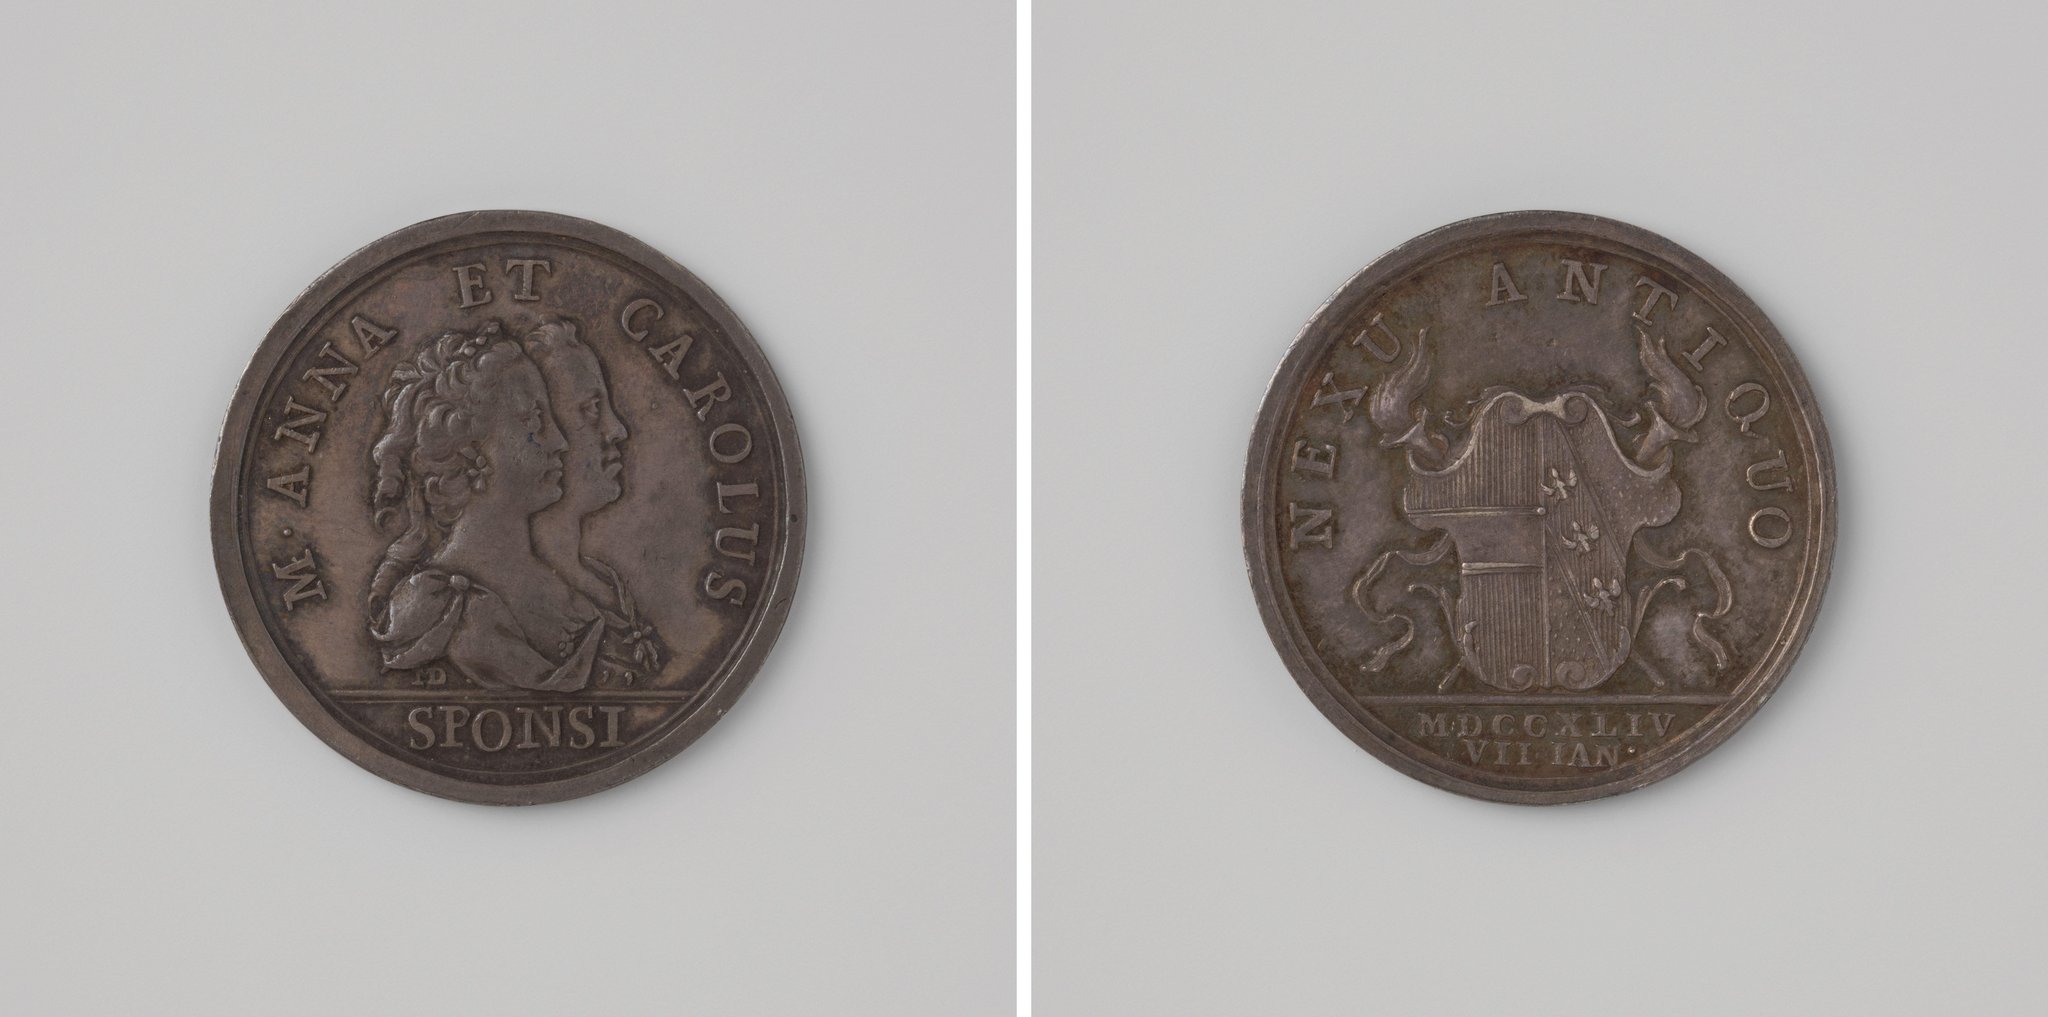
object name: history medal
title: Huwelijk van Maria Anna, aartshertogin van Oostenrijk met Karel Alexander, hertog van Lotharingen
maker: matthäus donner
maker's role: sculptor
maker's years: 1704-1756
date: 1744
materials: silver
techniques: striking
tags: karel alexander hertog van lotharingen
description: Zilveren penning. Voorzijde: borststuk vrouw met diadeem en man binnen omschrift. Keerzijde: wapenschild met twee brandende fakkels binnen omschrift; afsnede: datum